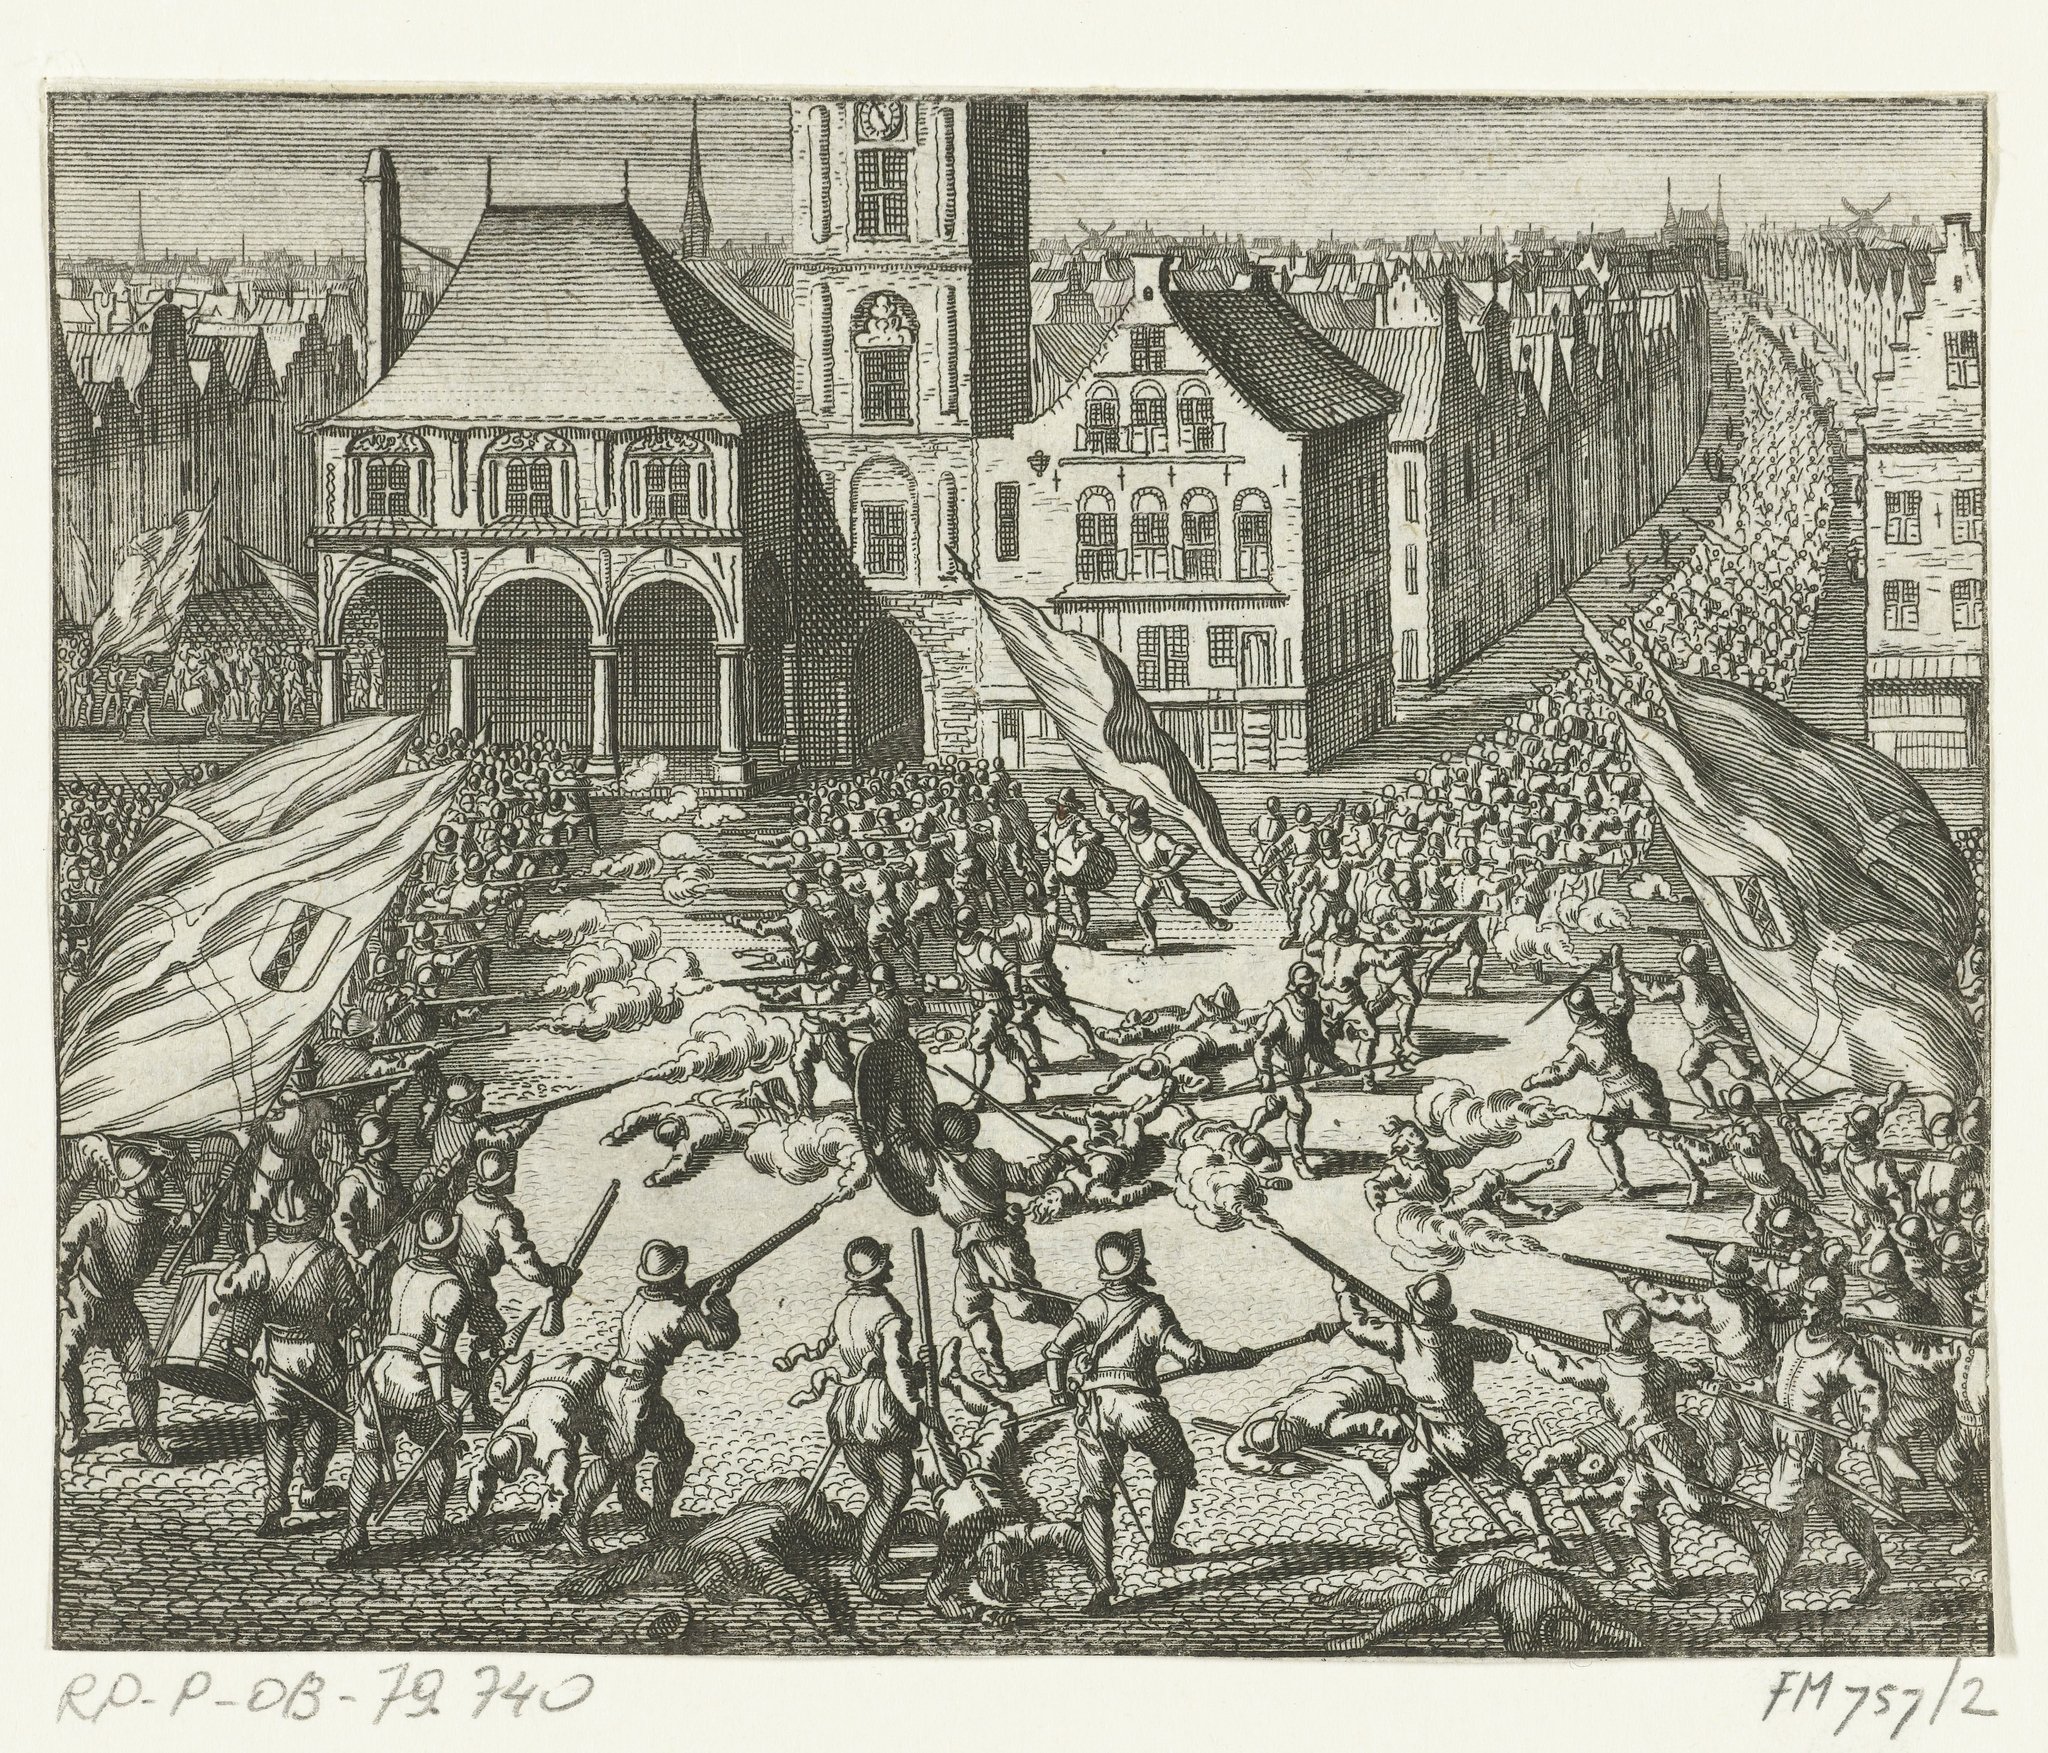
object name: print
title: Staatse troep verslagen op de Dam, 1577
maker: Anonymous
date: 1691-1693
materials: paper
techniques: etching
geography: northern netherlands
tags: amsterdam, haarlem, battle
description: De Staatse troepen onder bevel van Helling en Ruychaver worden bij felle gevechten op de Dam door de Amsterdammers verslagen. Helling zelf komt hierbij om het leven, 23 november 1577. Bedrukt op achterzijde met tekst in het Nederlands.